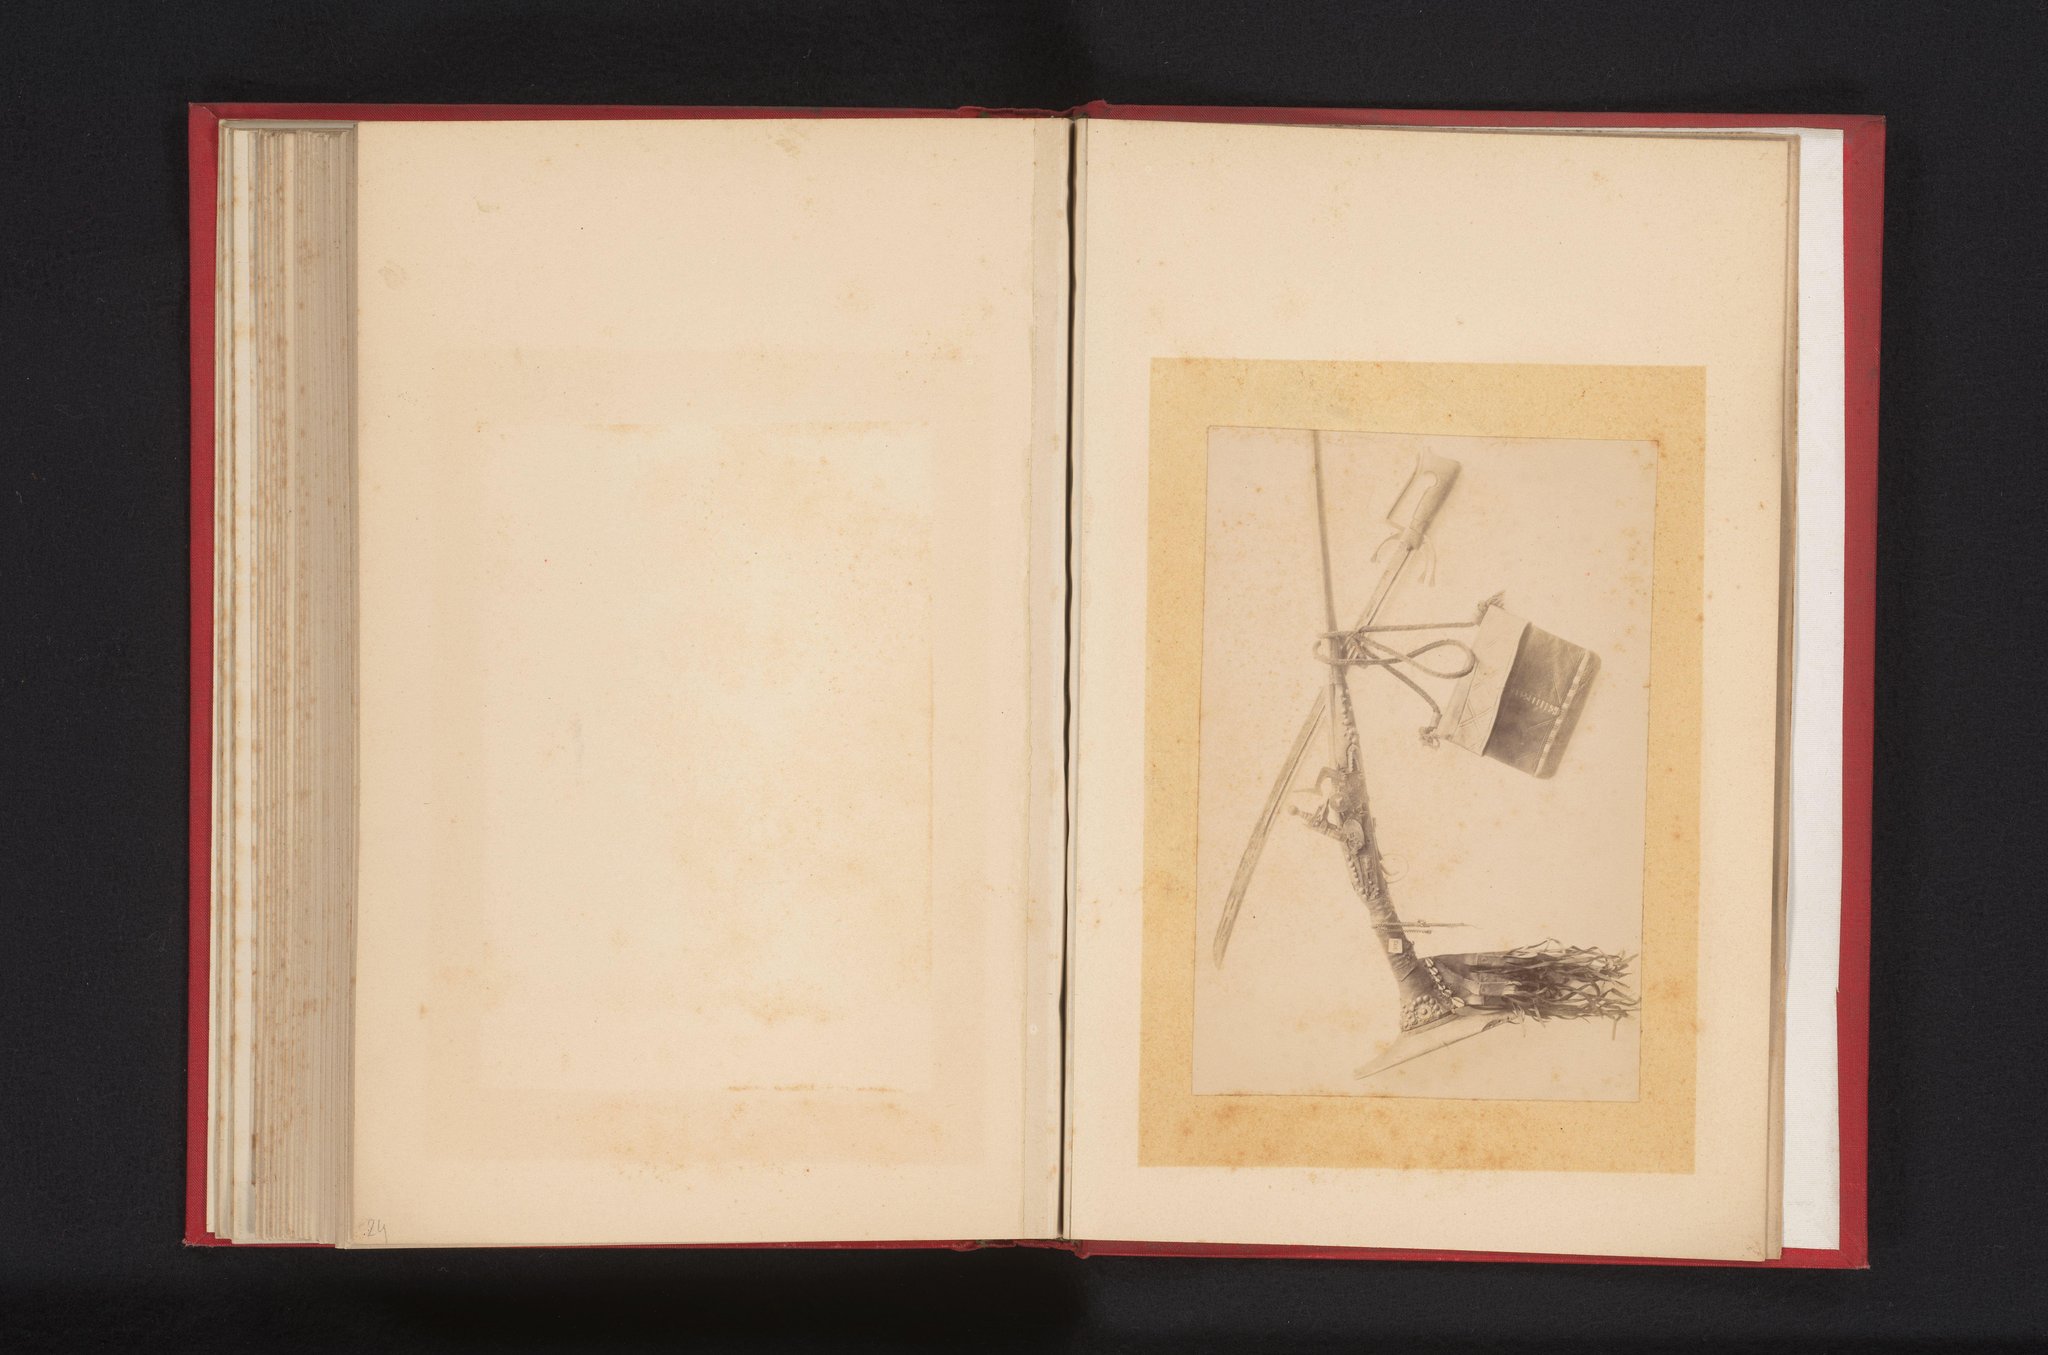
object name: page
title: Sabel, jachtgeweer en een handtas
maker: Anonymous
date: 1873-1878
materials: photographic support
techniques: albumen print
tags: purse, money-bag, hacking and thrusting weapons (with name), firearms